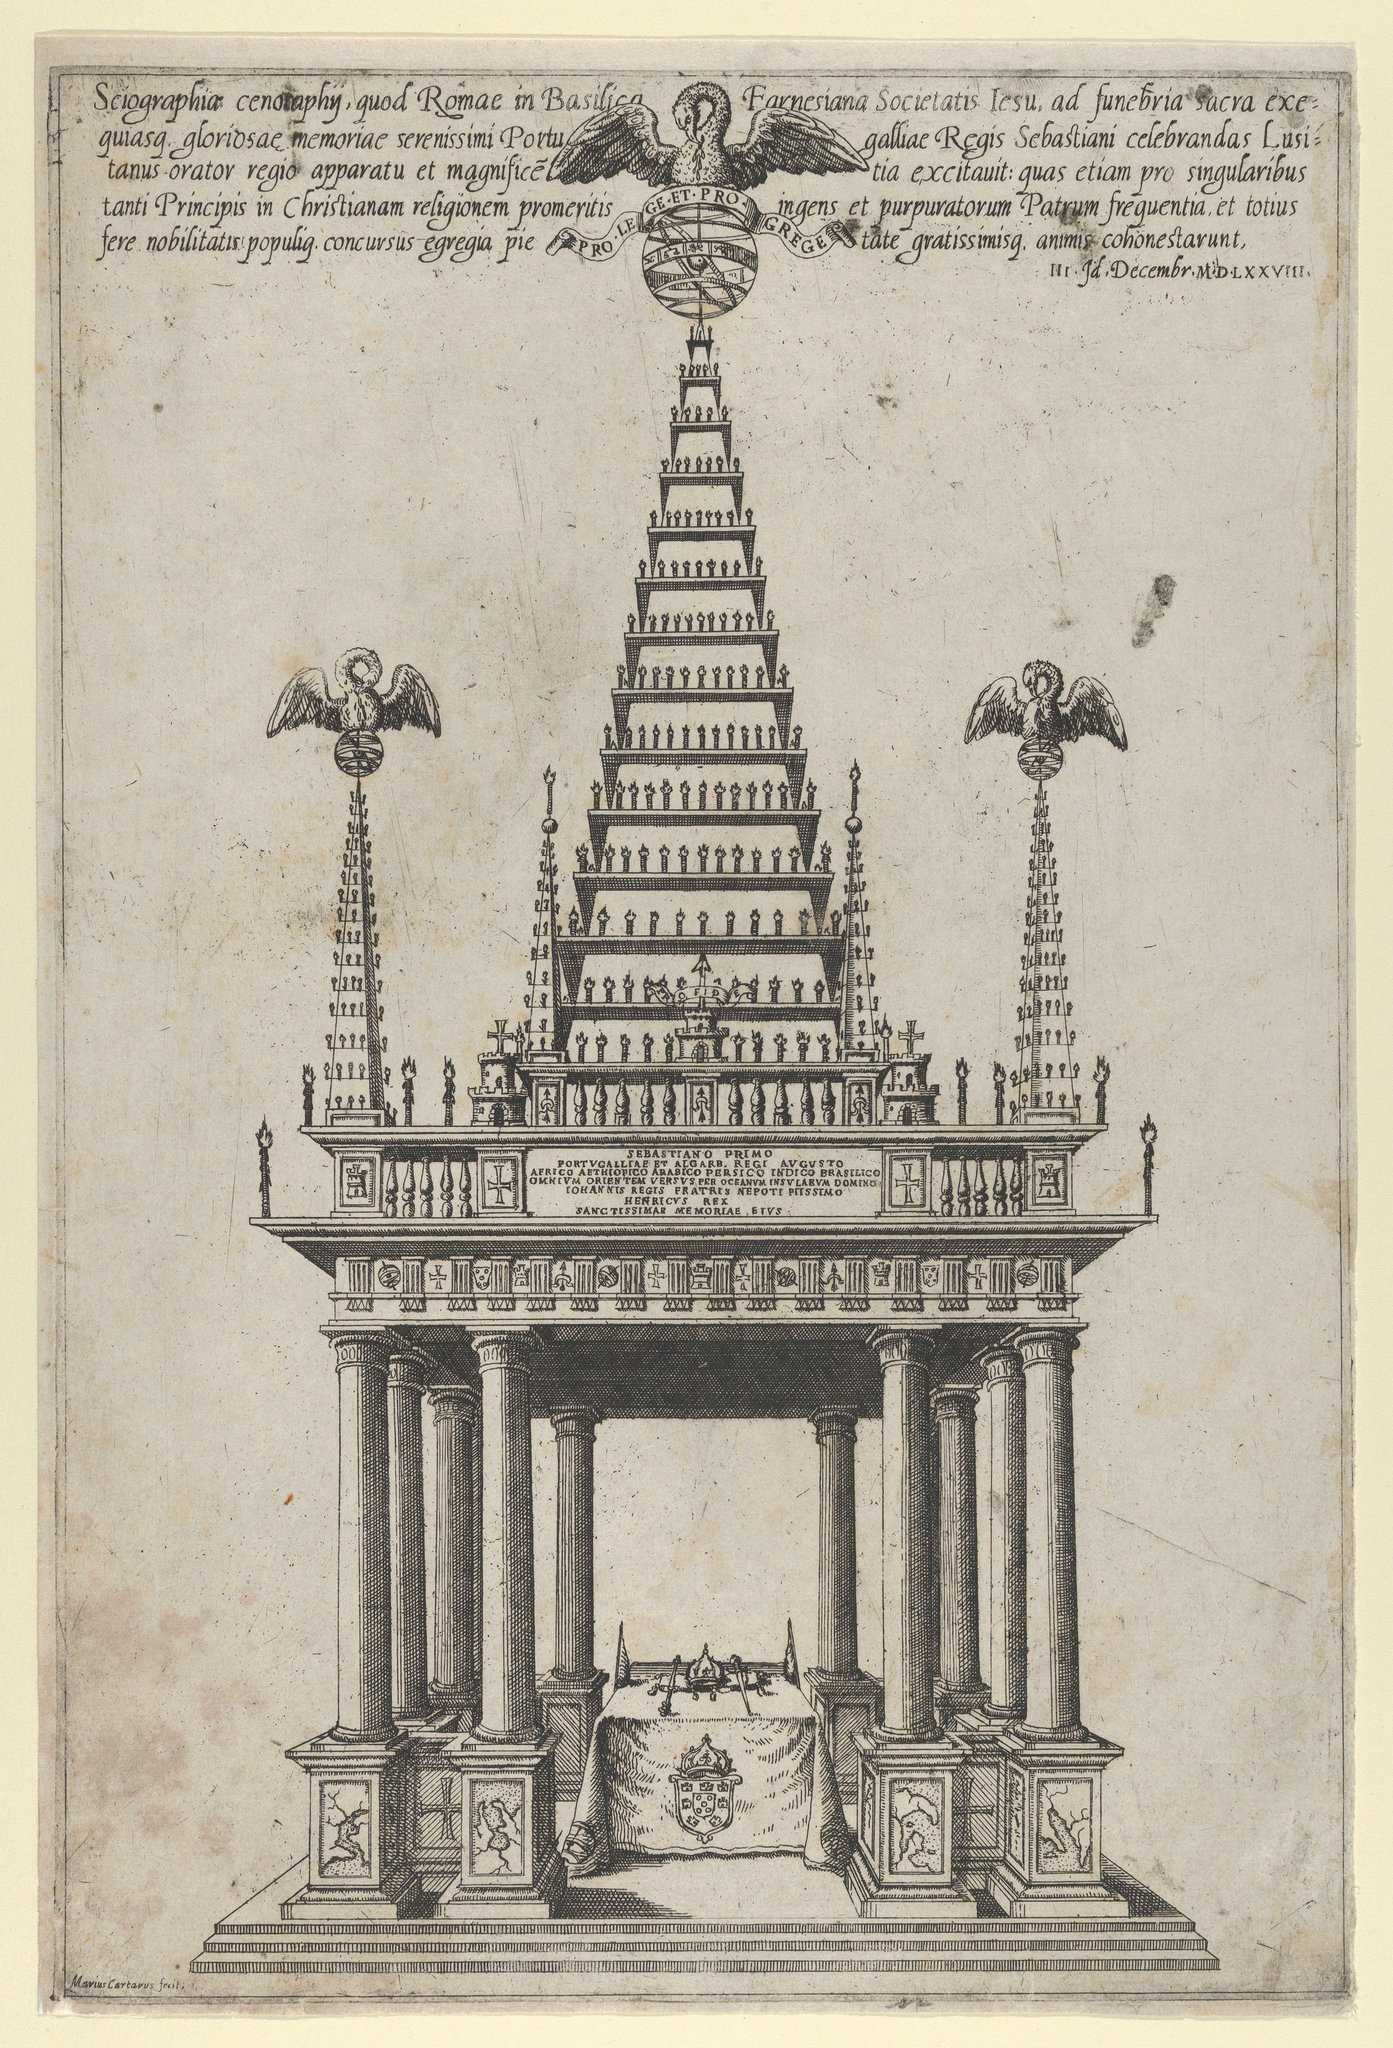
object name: print, fete, ornament architecture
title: Cenotaph for Sebastian I, King of Portugal, Basilica Farnesina, Rome, December 3, 1578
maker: mario cartaro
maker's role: artist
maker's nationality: italian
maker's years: 1557-1620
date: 1578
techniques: etching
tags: birds,monuments,coat of arms